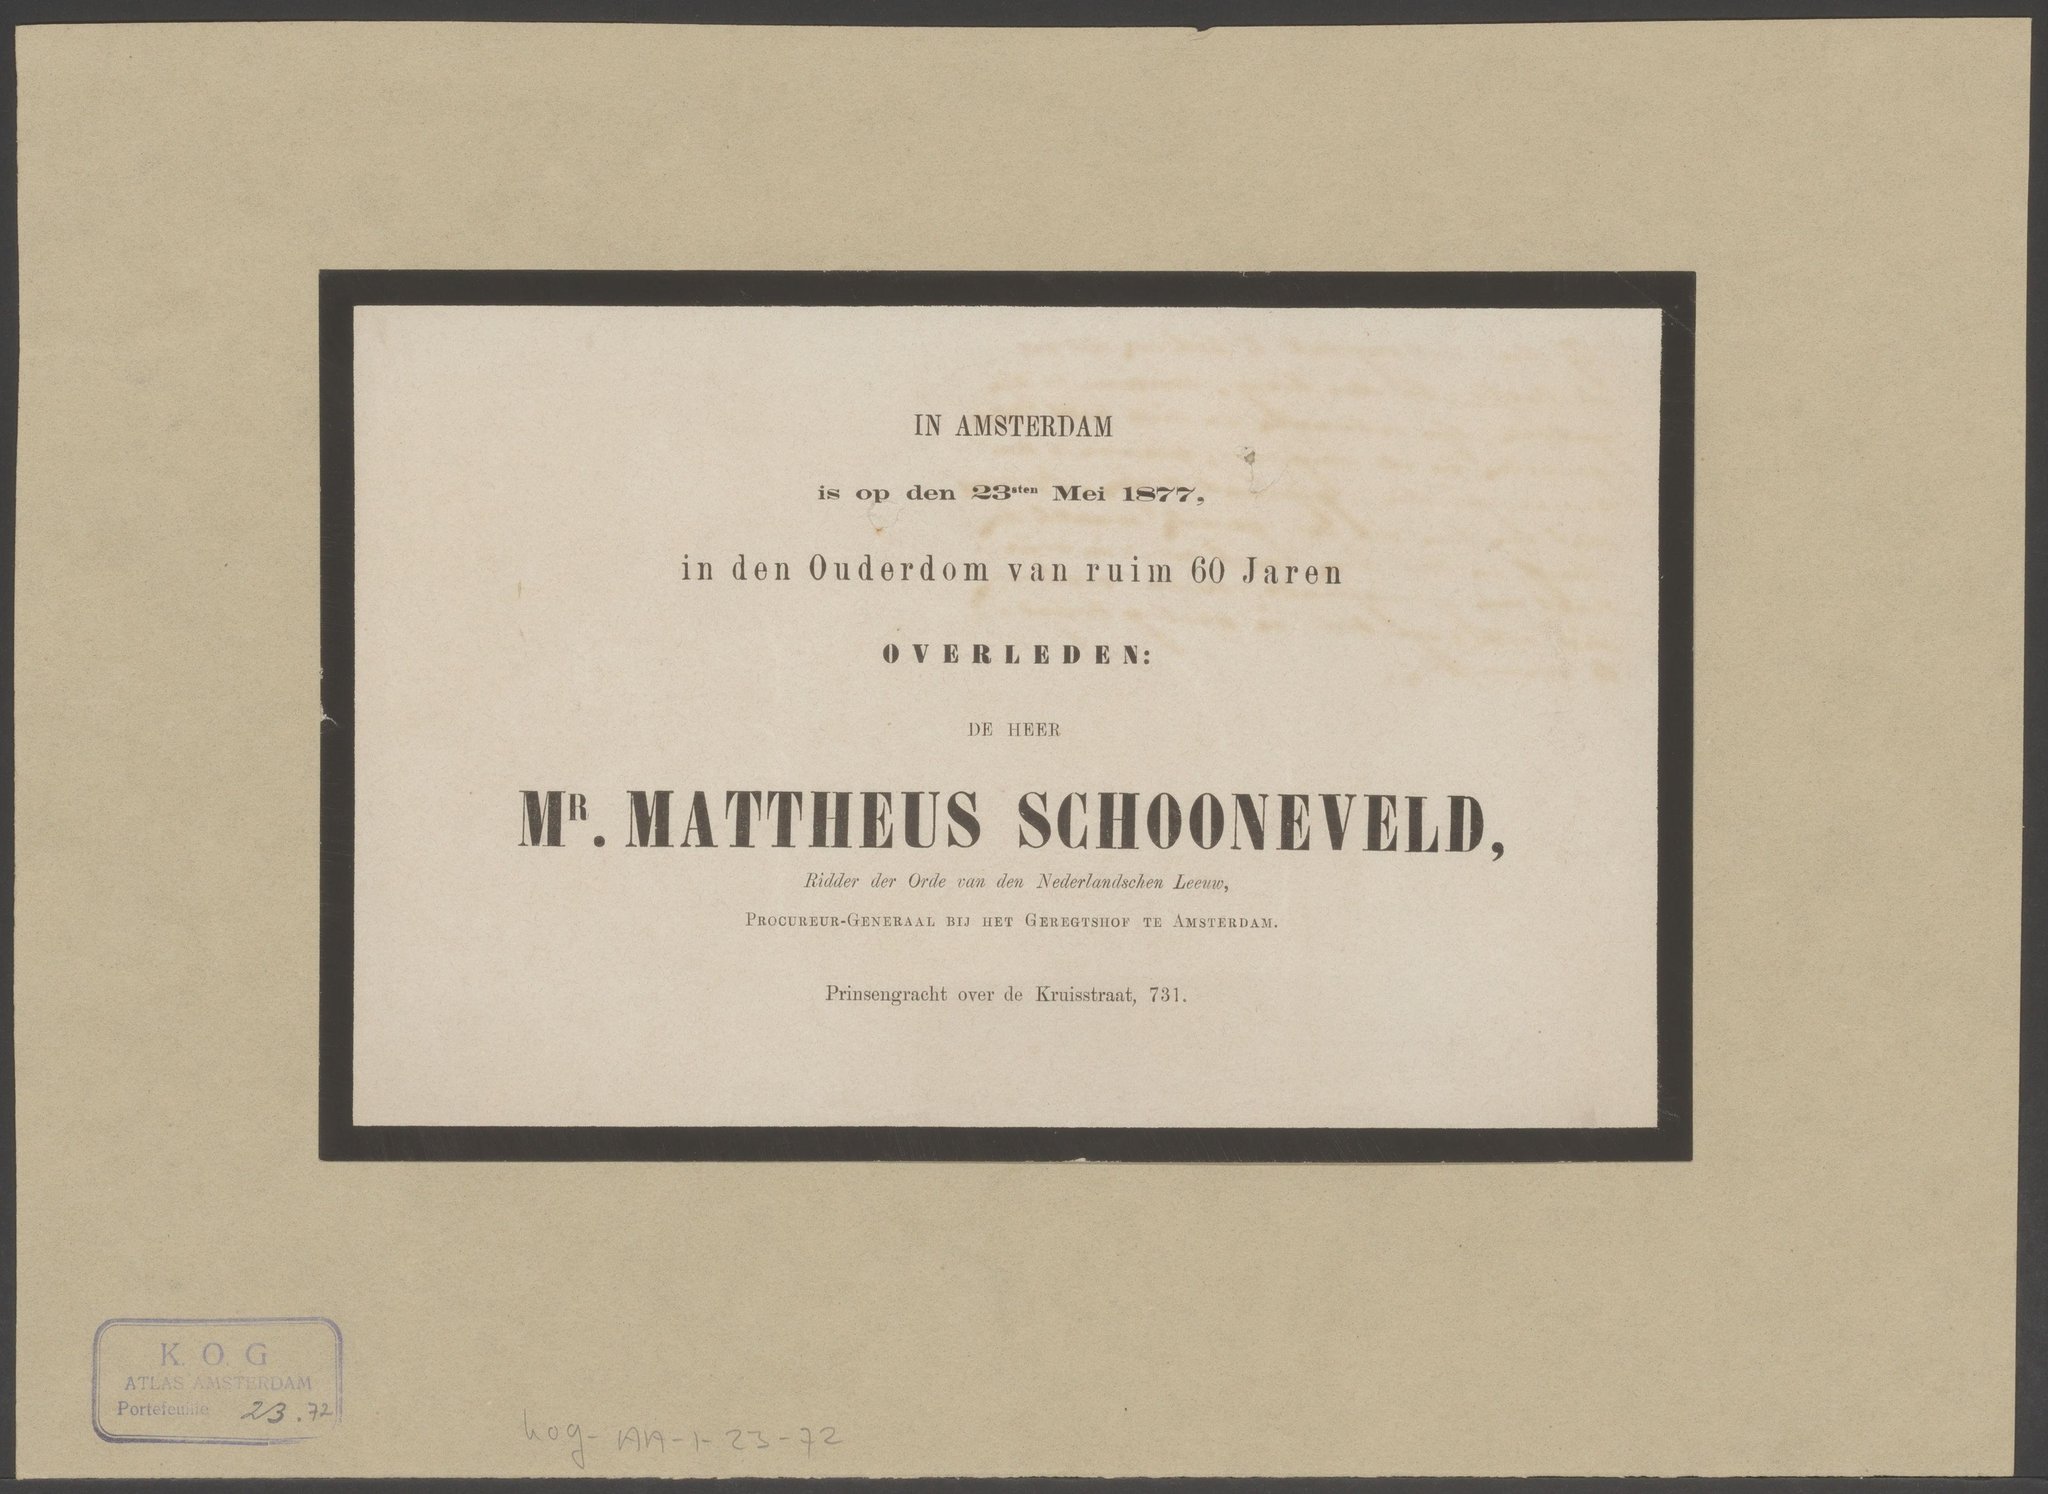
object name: overlijdensbericht, overlijdensadvertentie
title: Overlijdensbericht van Mattheus Schooneveld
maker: Anonymous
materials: paper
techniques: letterpress printing, printing block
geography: netherlands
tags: amsterdam, mourning card, death notice, obituary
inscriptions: collector's mark: Lugt 1641b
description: Onderwerpsrubriek binnen de Atlas Amsterdam: Rechtswezen.